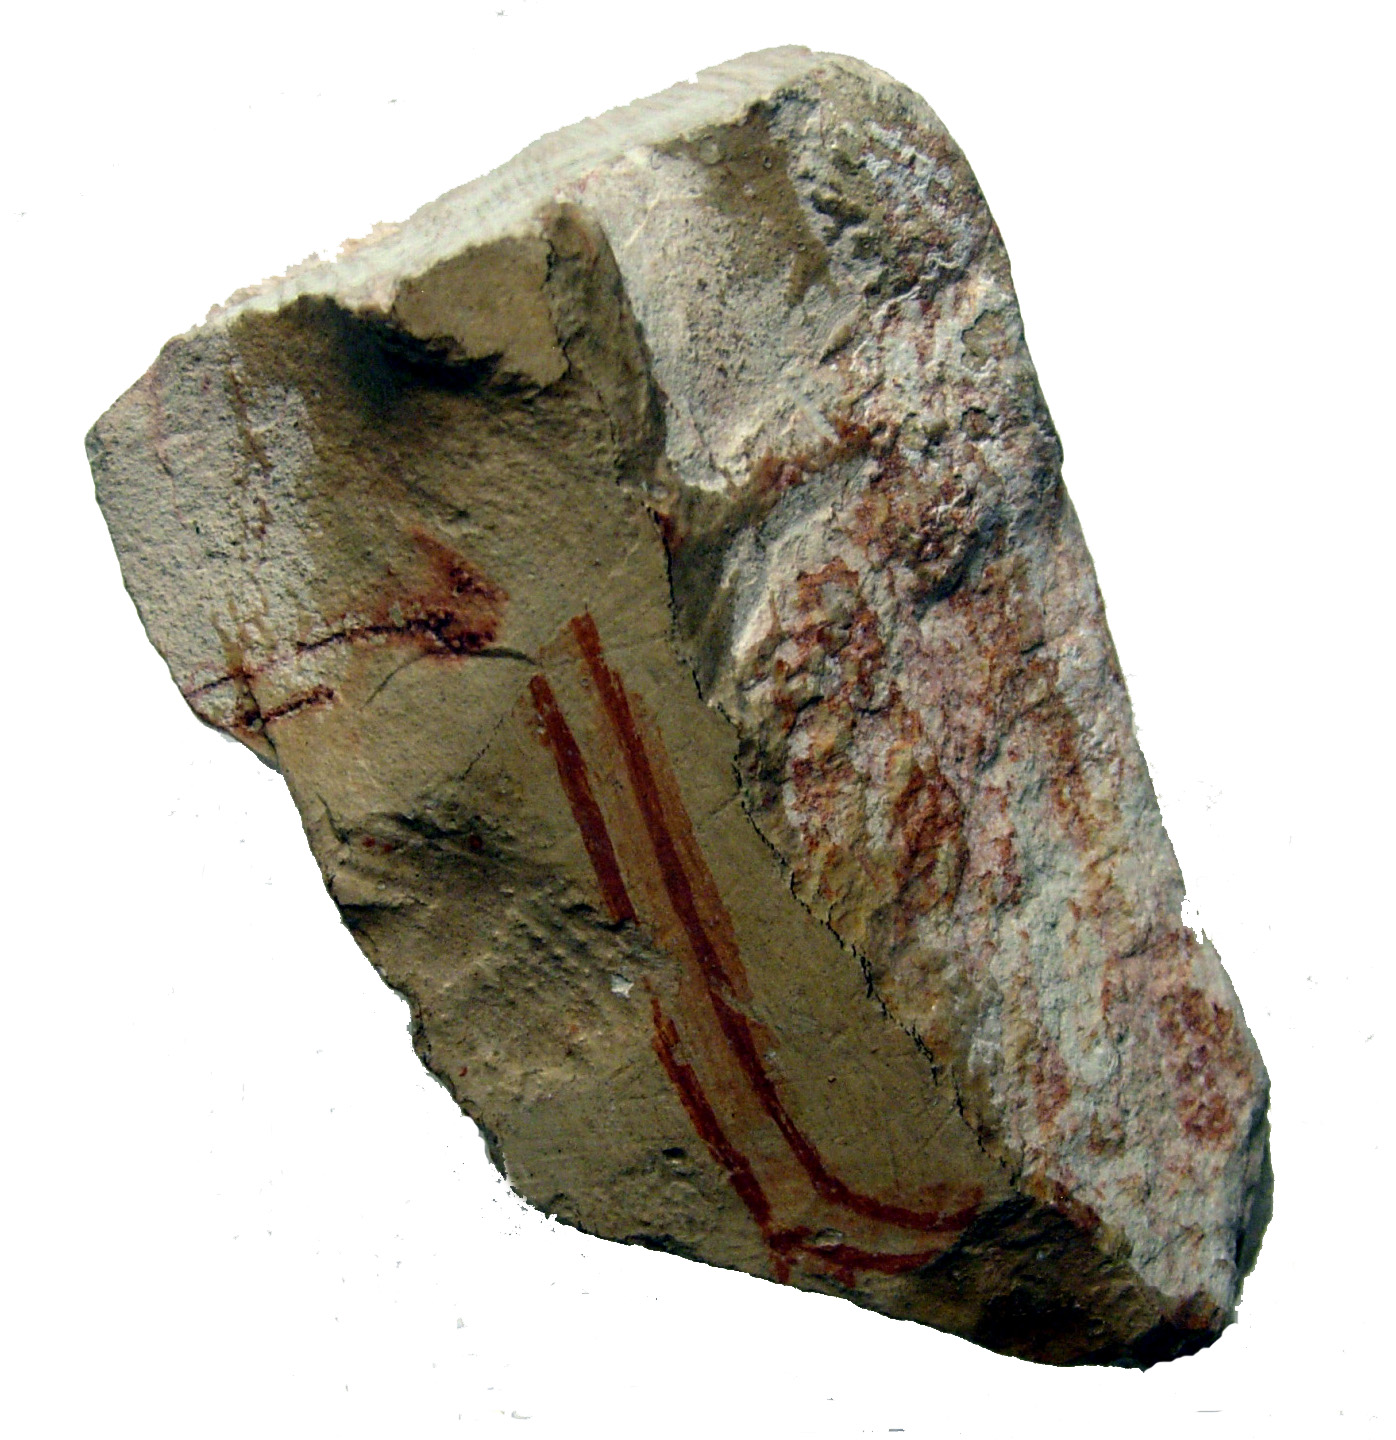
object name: relief, tomb of nespekashuty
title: Drawing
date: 664-610 BCE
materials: limestone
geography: egypt